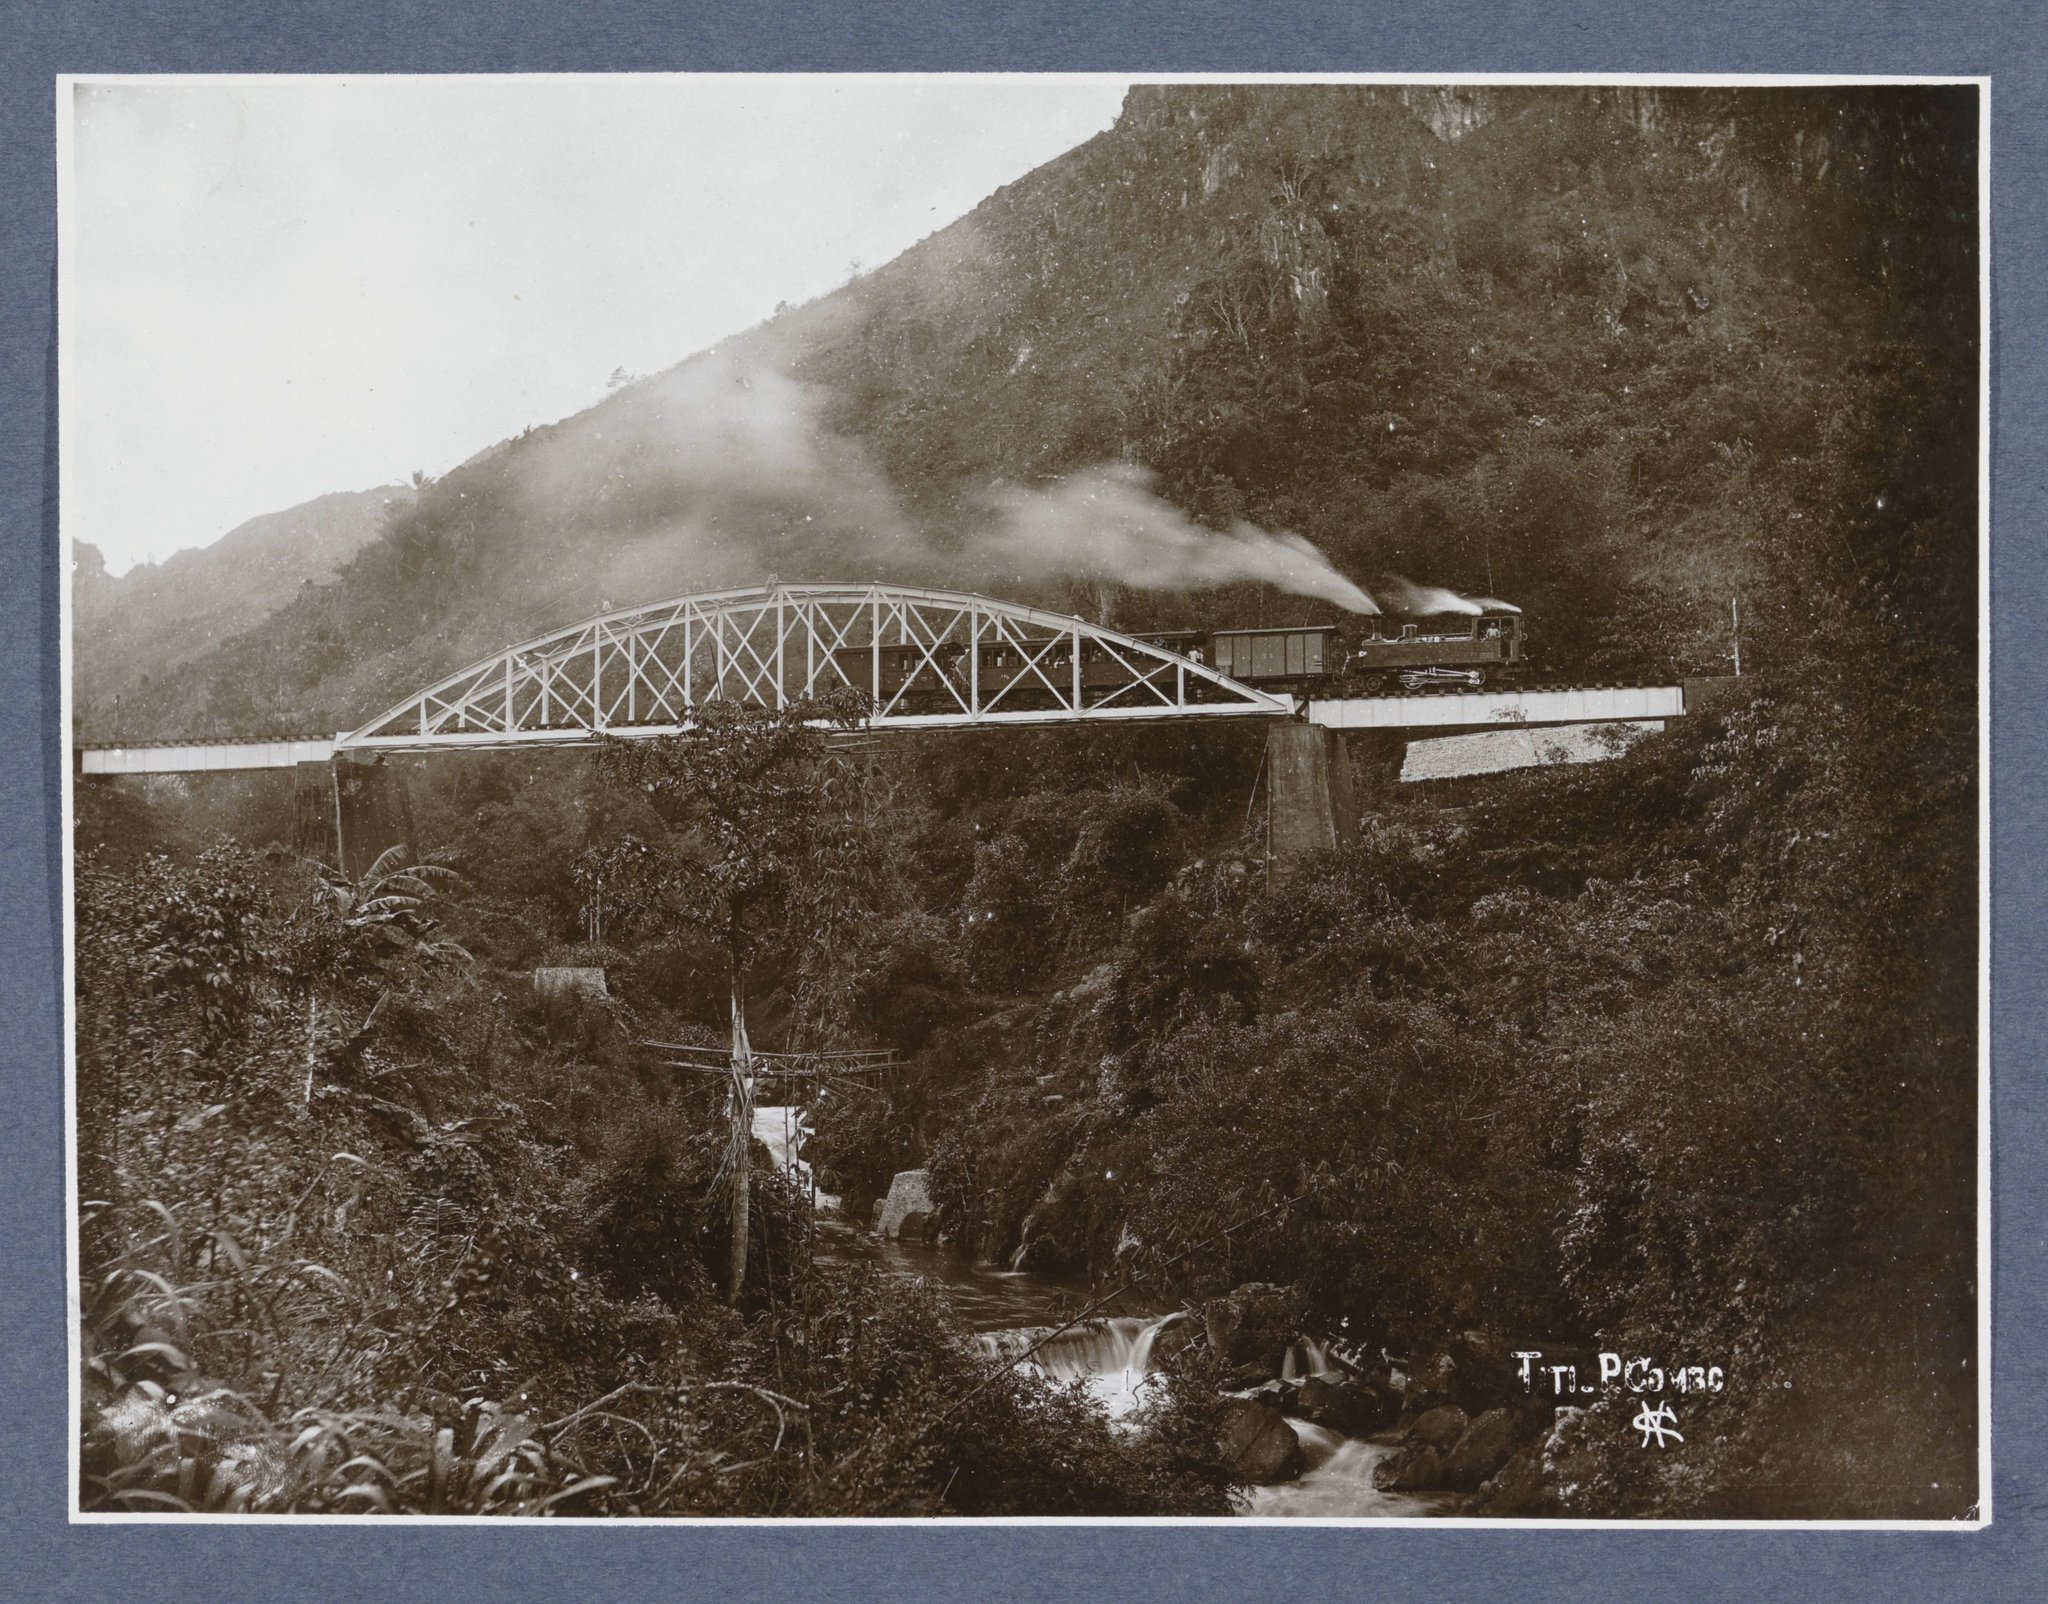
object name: photograph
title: Titi.P.Combo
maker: christiaan benjamin nieuwenhuis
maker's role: publisher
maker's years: 1863-1922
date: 1900-1920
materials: paper, photographic support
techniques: gelatin silver print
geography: sumatra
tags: locomotive, railway wagon, landscape with bridge, viaduct or aqueduct, railway, train, sumatra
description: Onderdeel van reisalbum met foto's van bedrijvigheid en bezienswaardigheden op Sumatra en Java en van de reis naar en van Nederlands-Indië.